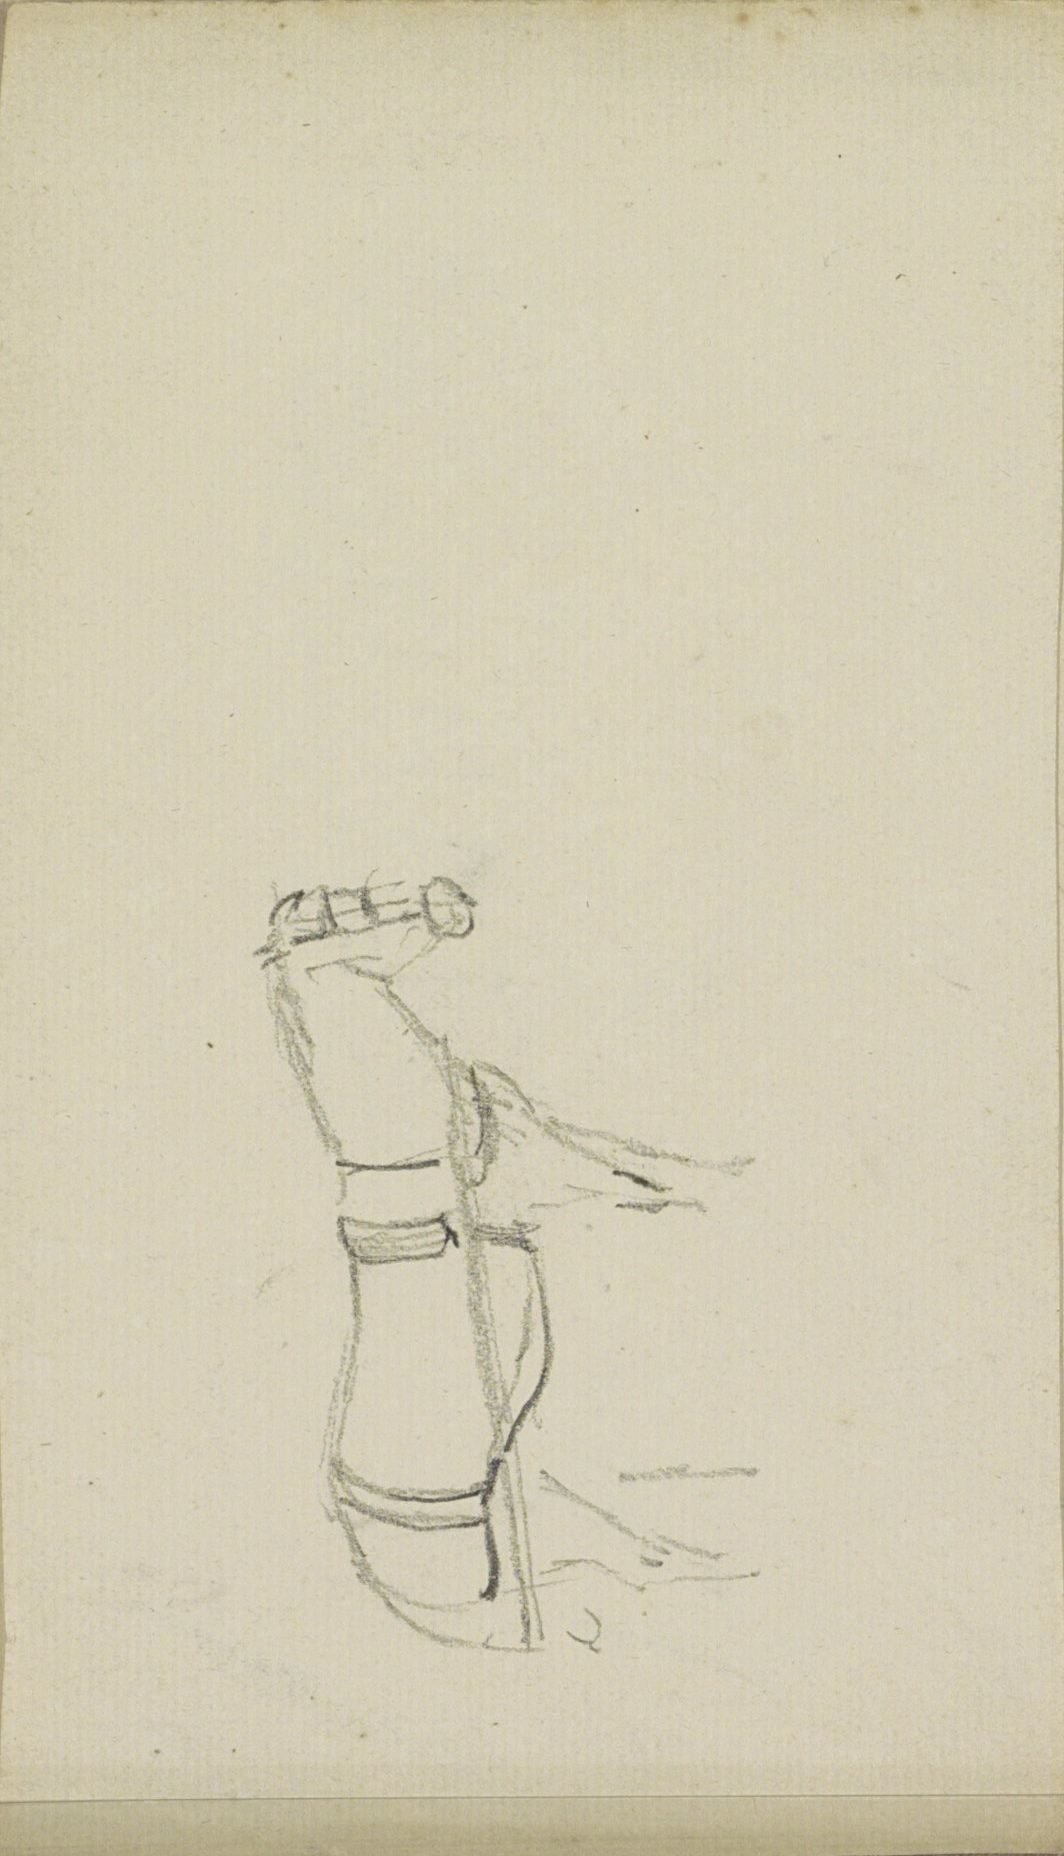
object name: drawing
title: Paard met paardentuig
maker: adrianus eversen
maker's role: draughtsman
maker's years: 1818-1897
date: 1828-1897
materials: paper, pencil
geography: netherlands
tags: horse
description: Paard met paardentuig, waaronder een hoofdstel. Recto van een losse tekening uit een schetsboek met 69 bladen vervaardigd in de omgeving van Delft, Rotterdam, Oudewater en Harlingen.